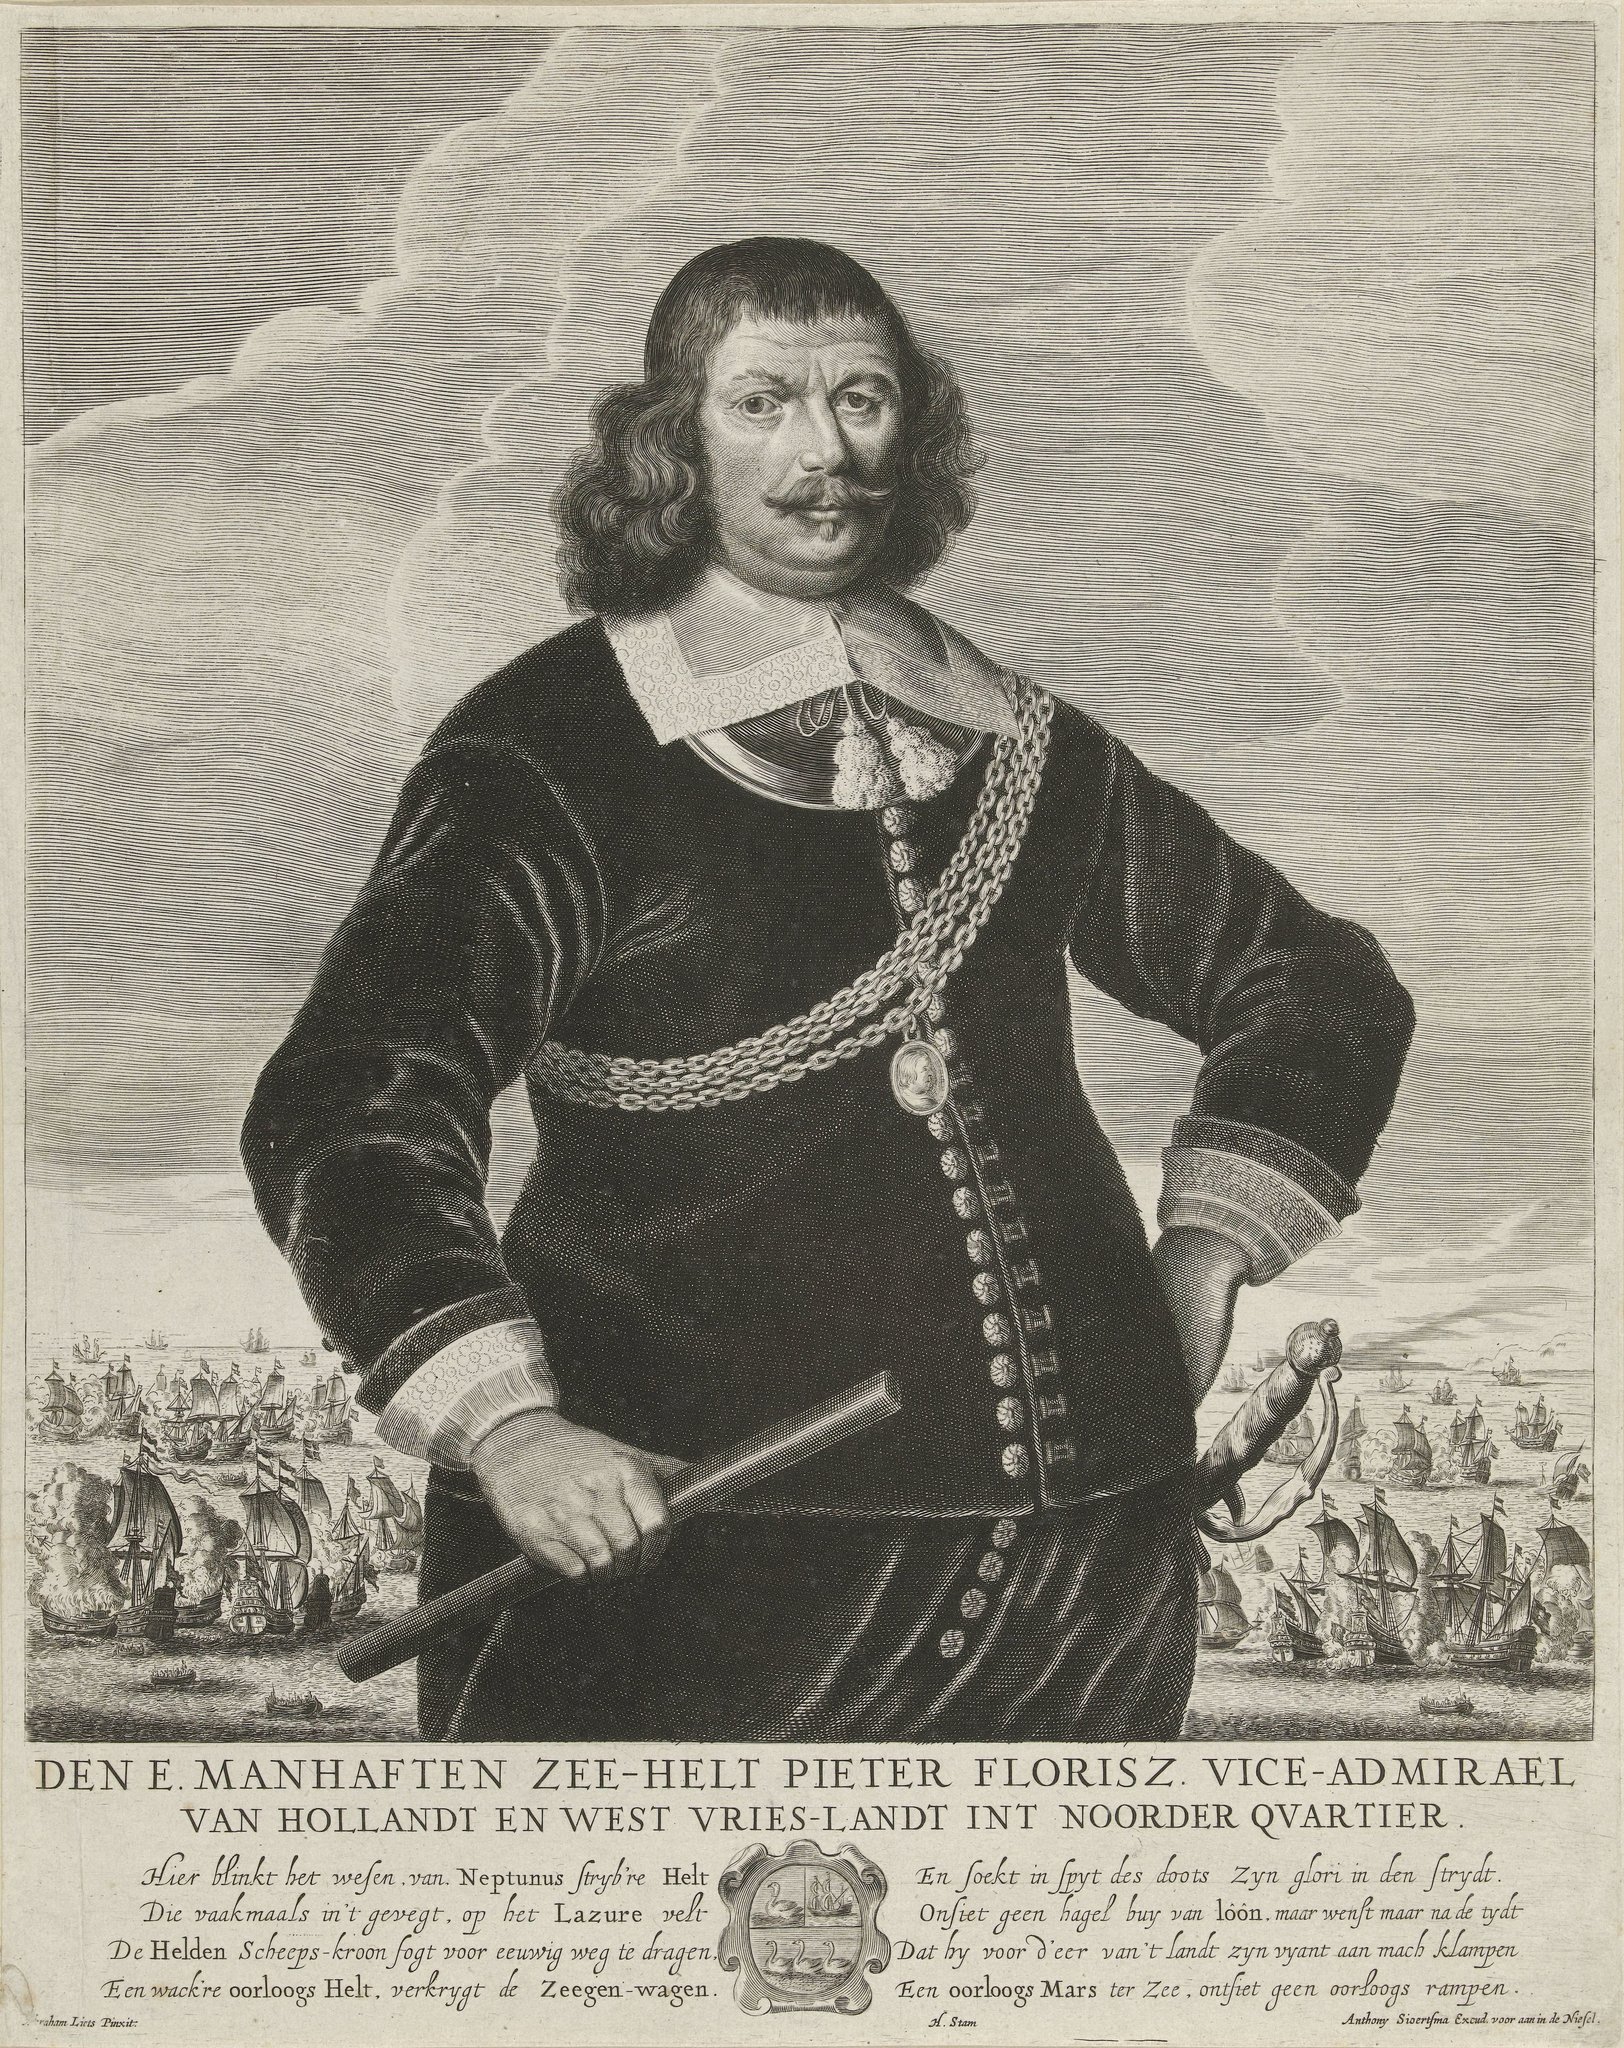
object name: print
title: Portret van Pieter Florisse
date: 1658-1673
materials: paper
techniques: engraving, etching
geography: northern netherlands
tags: sont, vice-admiraal, pieter florisse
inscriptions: collector's mark: Lugt 2228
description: Kniestuk naar rechts van Pieter Florisz. met in zijn hand een commandostaf. Op de achtergrond een zeeslag. Onder het portret zijn naam en titel in twee regels in het Nederlands. Daaronder in twee kolommen van elk vier regels een gedicht in het Nederlands en zijn wapen.